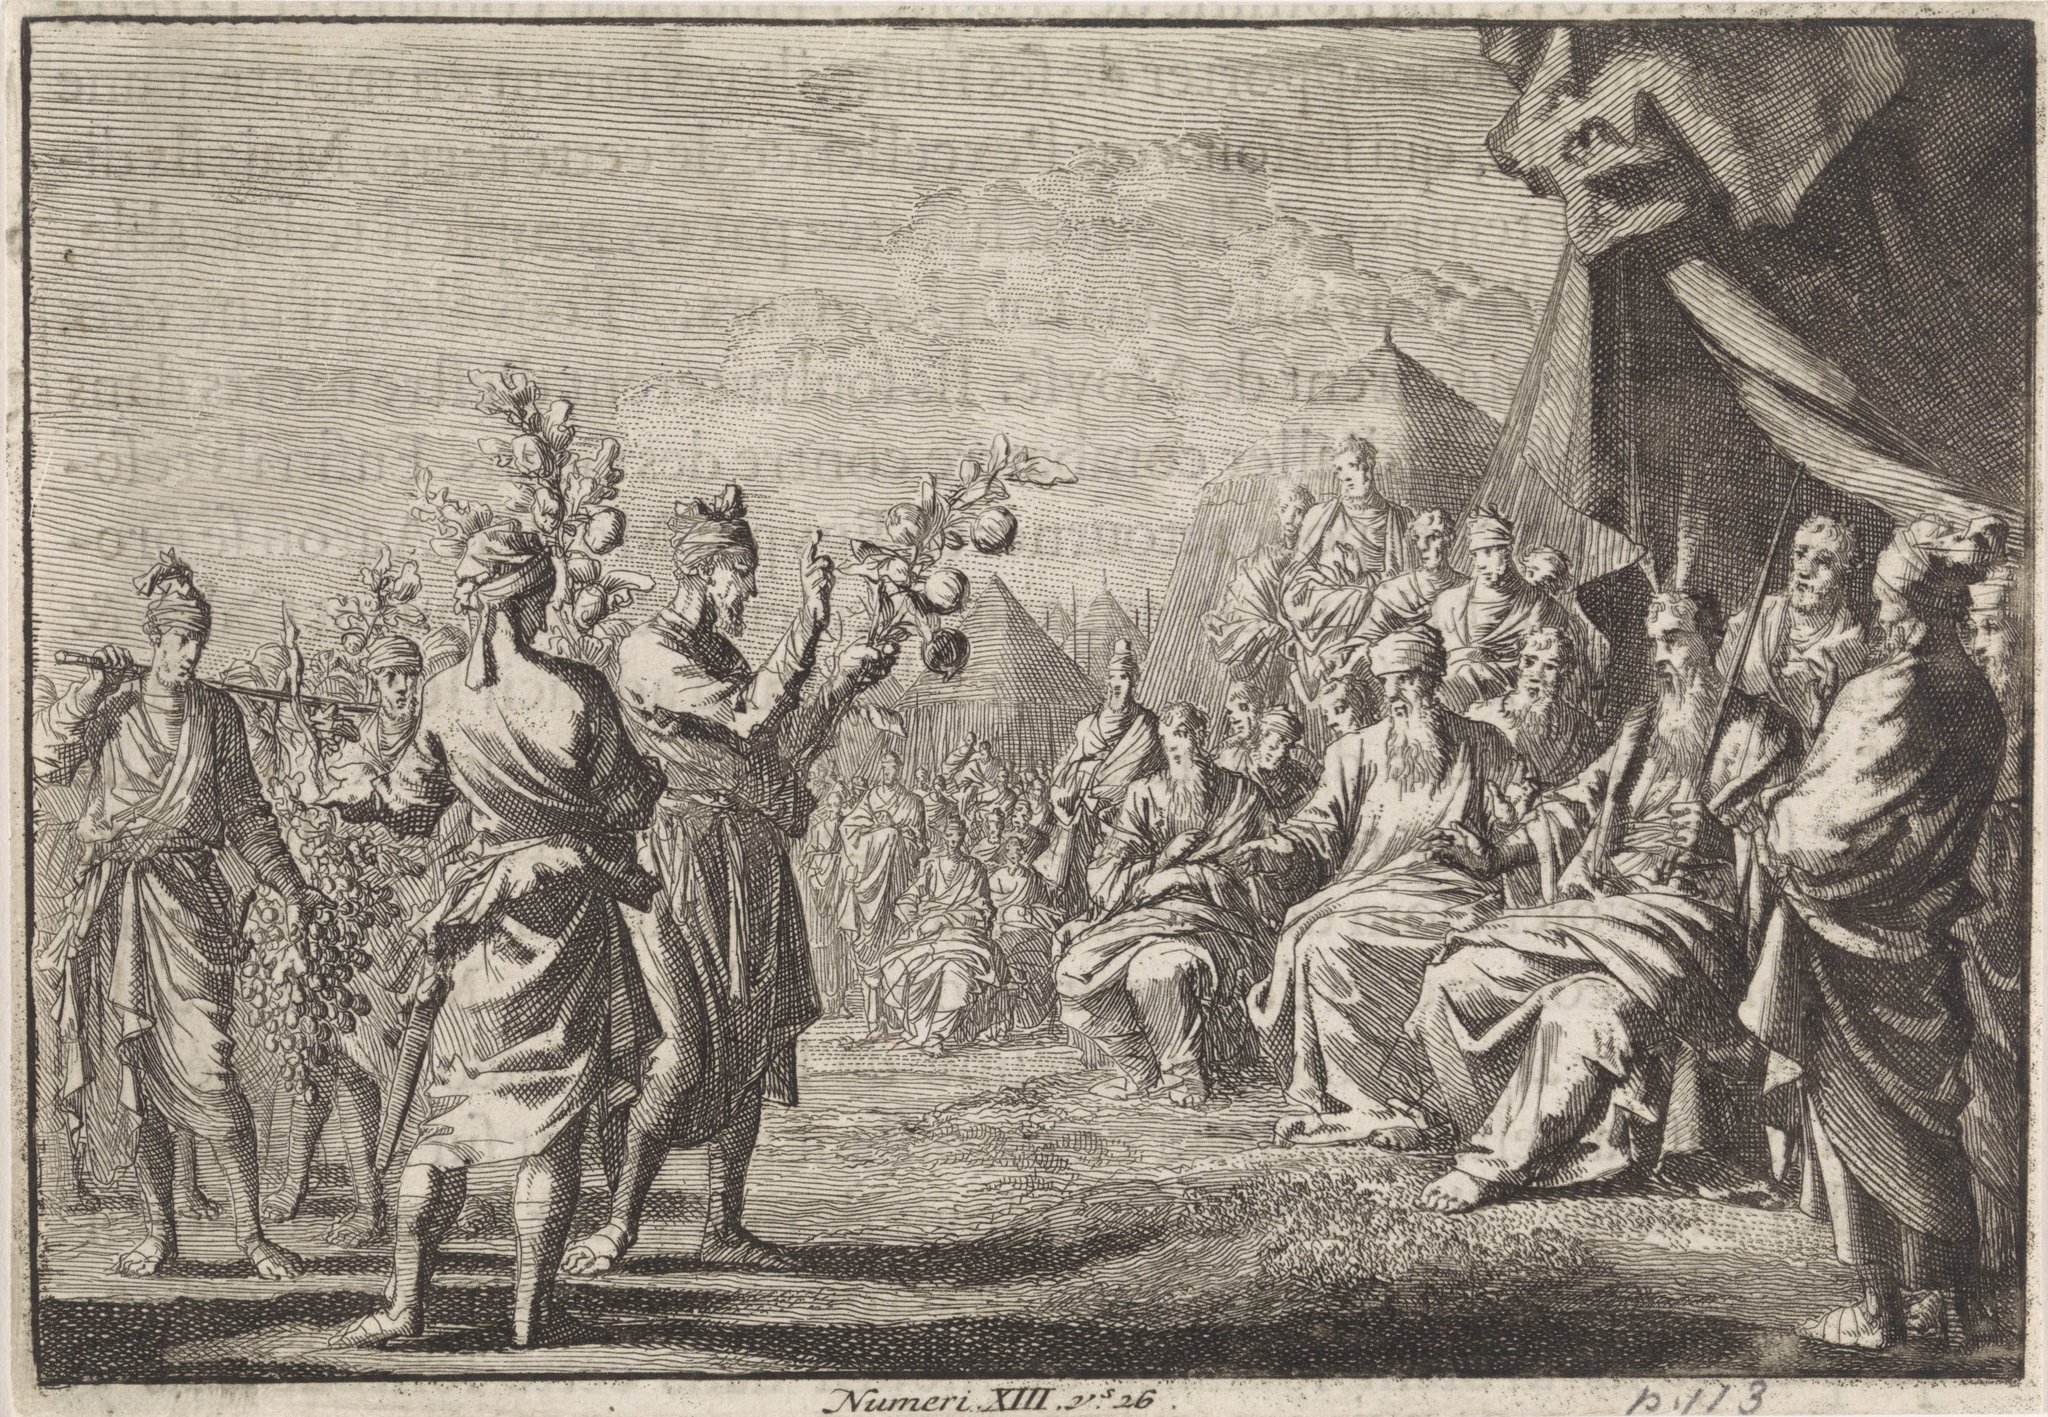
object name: book illustration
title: Terugkeer van de verkenners uit Kanaän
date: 1703-1762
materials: paper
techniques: etching, letterpress printing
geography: haarlem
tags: the spies take away some of the fruits of canaan and return, usually carrying a large bunch of grapes on a pole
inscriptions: collector's mark: Lugt 2228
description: De prent komt een eerste keer voor als boekillustratie voor David Martin. Historie des Ouden en Nieuwen Testaments. Amsterdam, Pieter Mortier, 1703. Deel I. De boekillustraties voor de Mortierbijbel hebben verschillende staten en kopieën, waarbij de chronologische volgorde moeilijk te achterhalen valt. Als boekillustraties werden ze bovendien herhaaldelijk opnieuw gebruikt voor andere boekwerken.